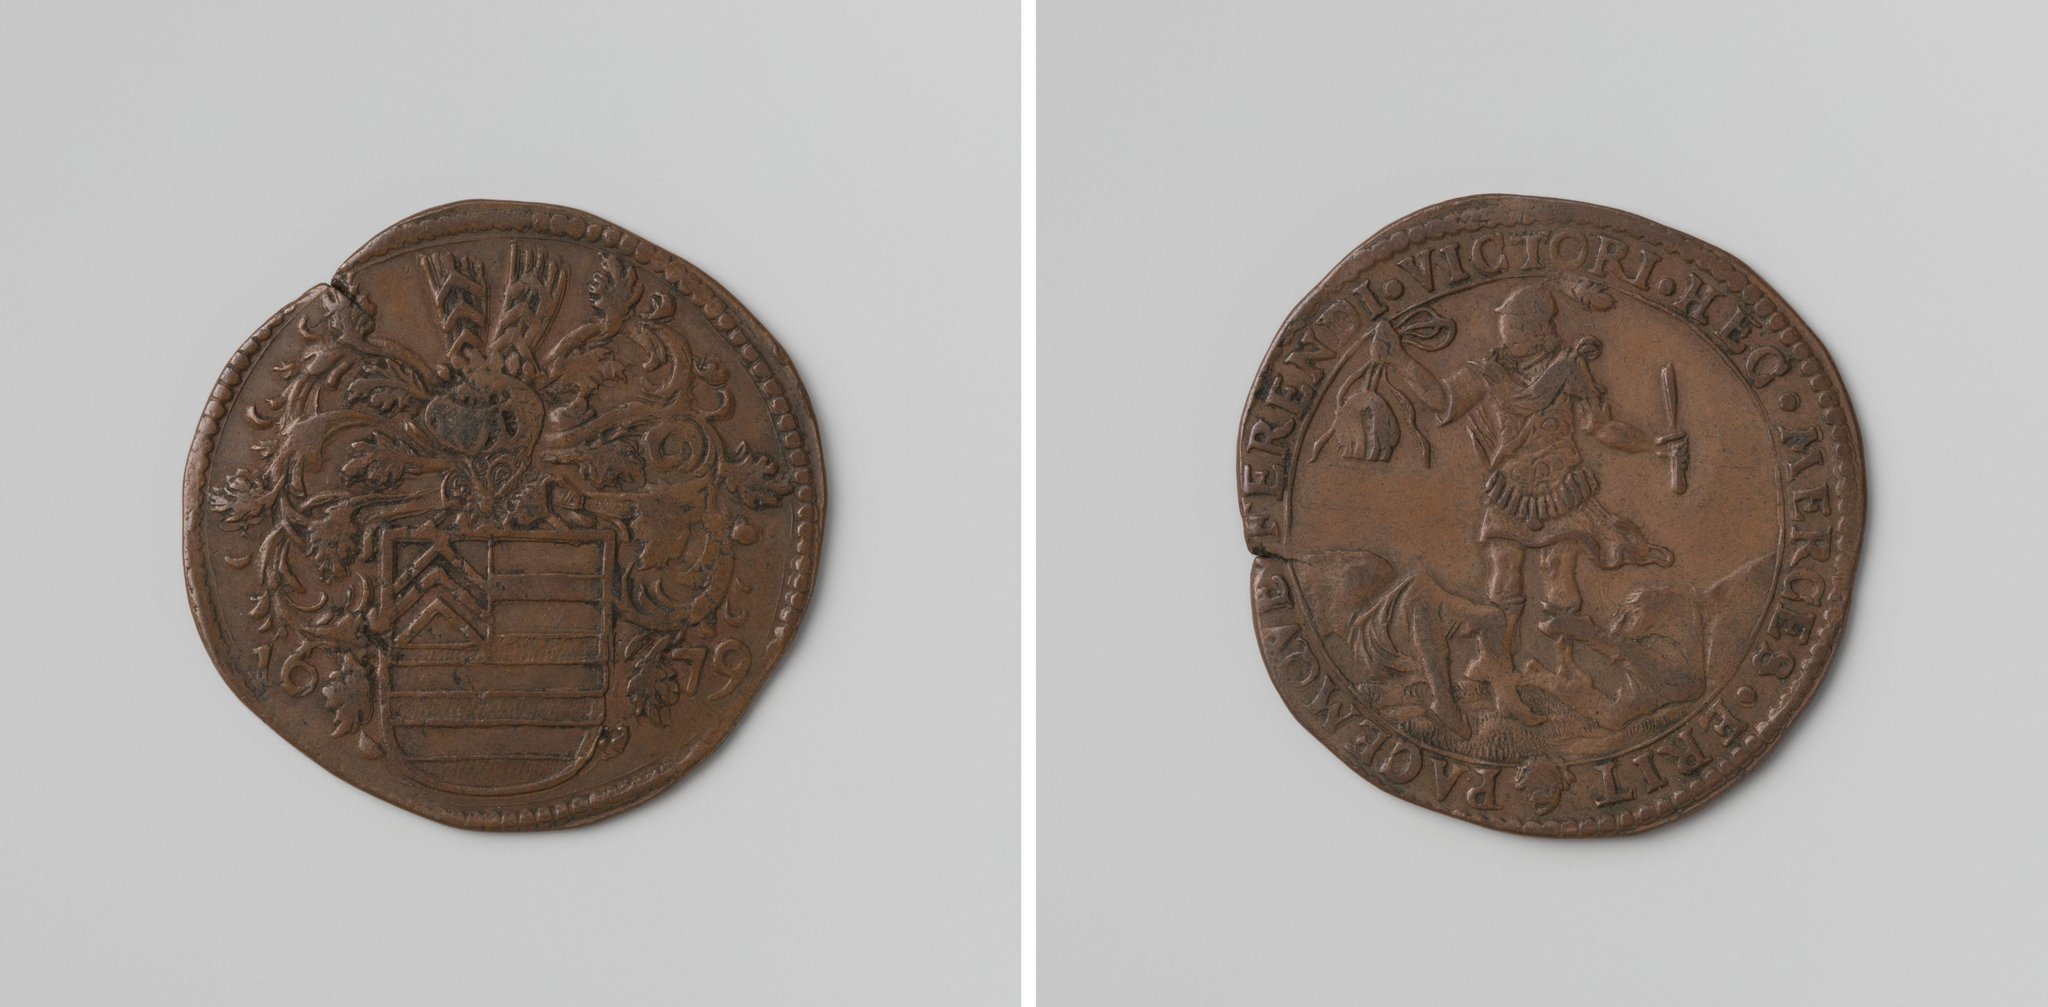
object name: jeton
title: Vrede van Nijmegen, rekenpenning van Philippe Godefroid Vande Wouwere, magistraat van de schatkist van Brussel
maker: Anonymous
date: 1601-1679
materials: copper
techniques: striking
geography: brussels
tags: brussels, nijmegen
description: Koperen penning. Voorzijde: gehelmd wapenschild tussen jaartal. Keerzijde: Jason met zwaard en Gulden Vlies in handen, staande temidden van twee ter aarde liggende mannen binnen omschrift